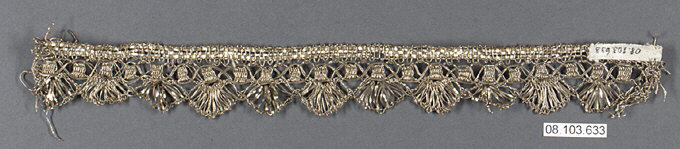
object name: piece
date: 1701-1900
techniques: lace